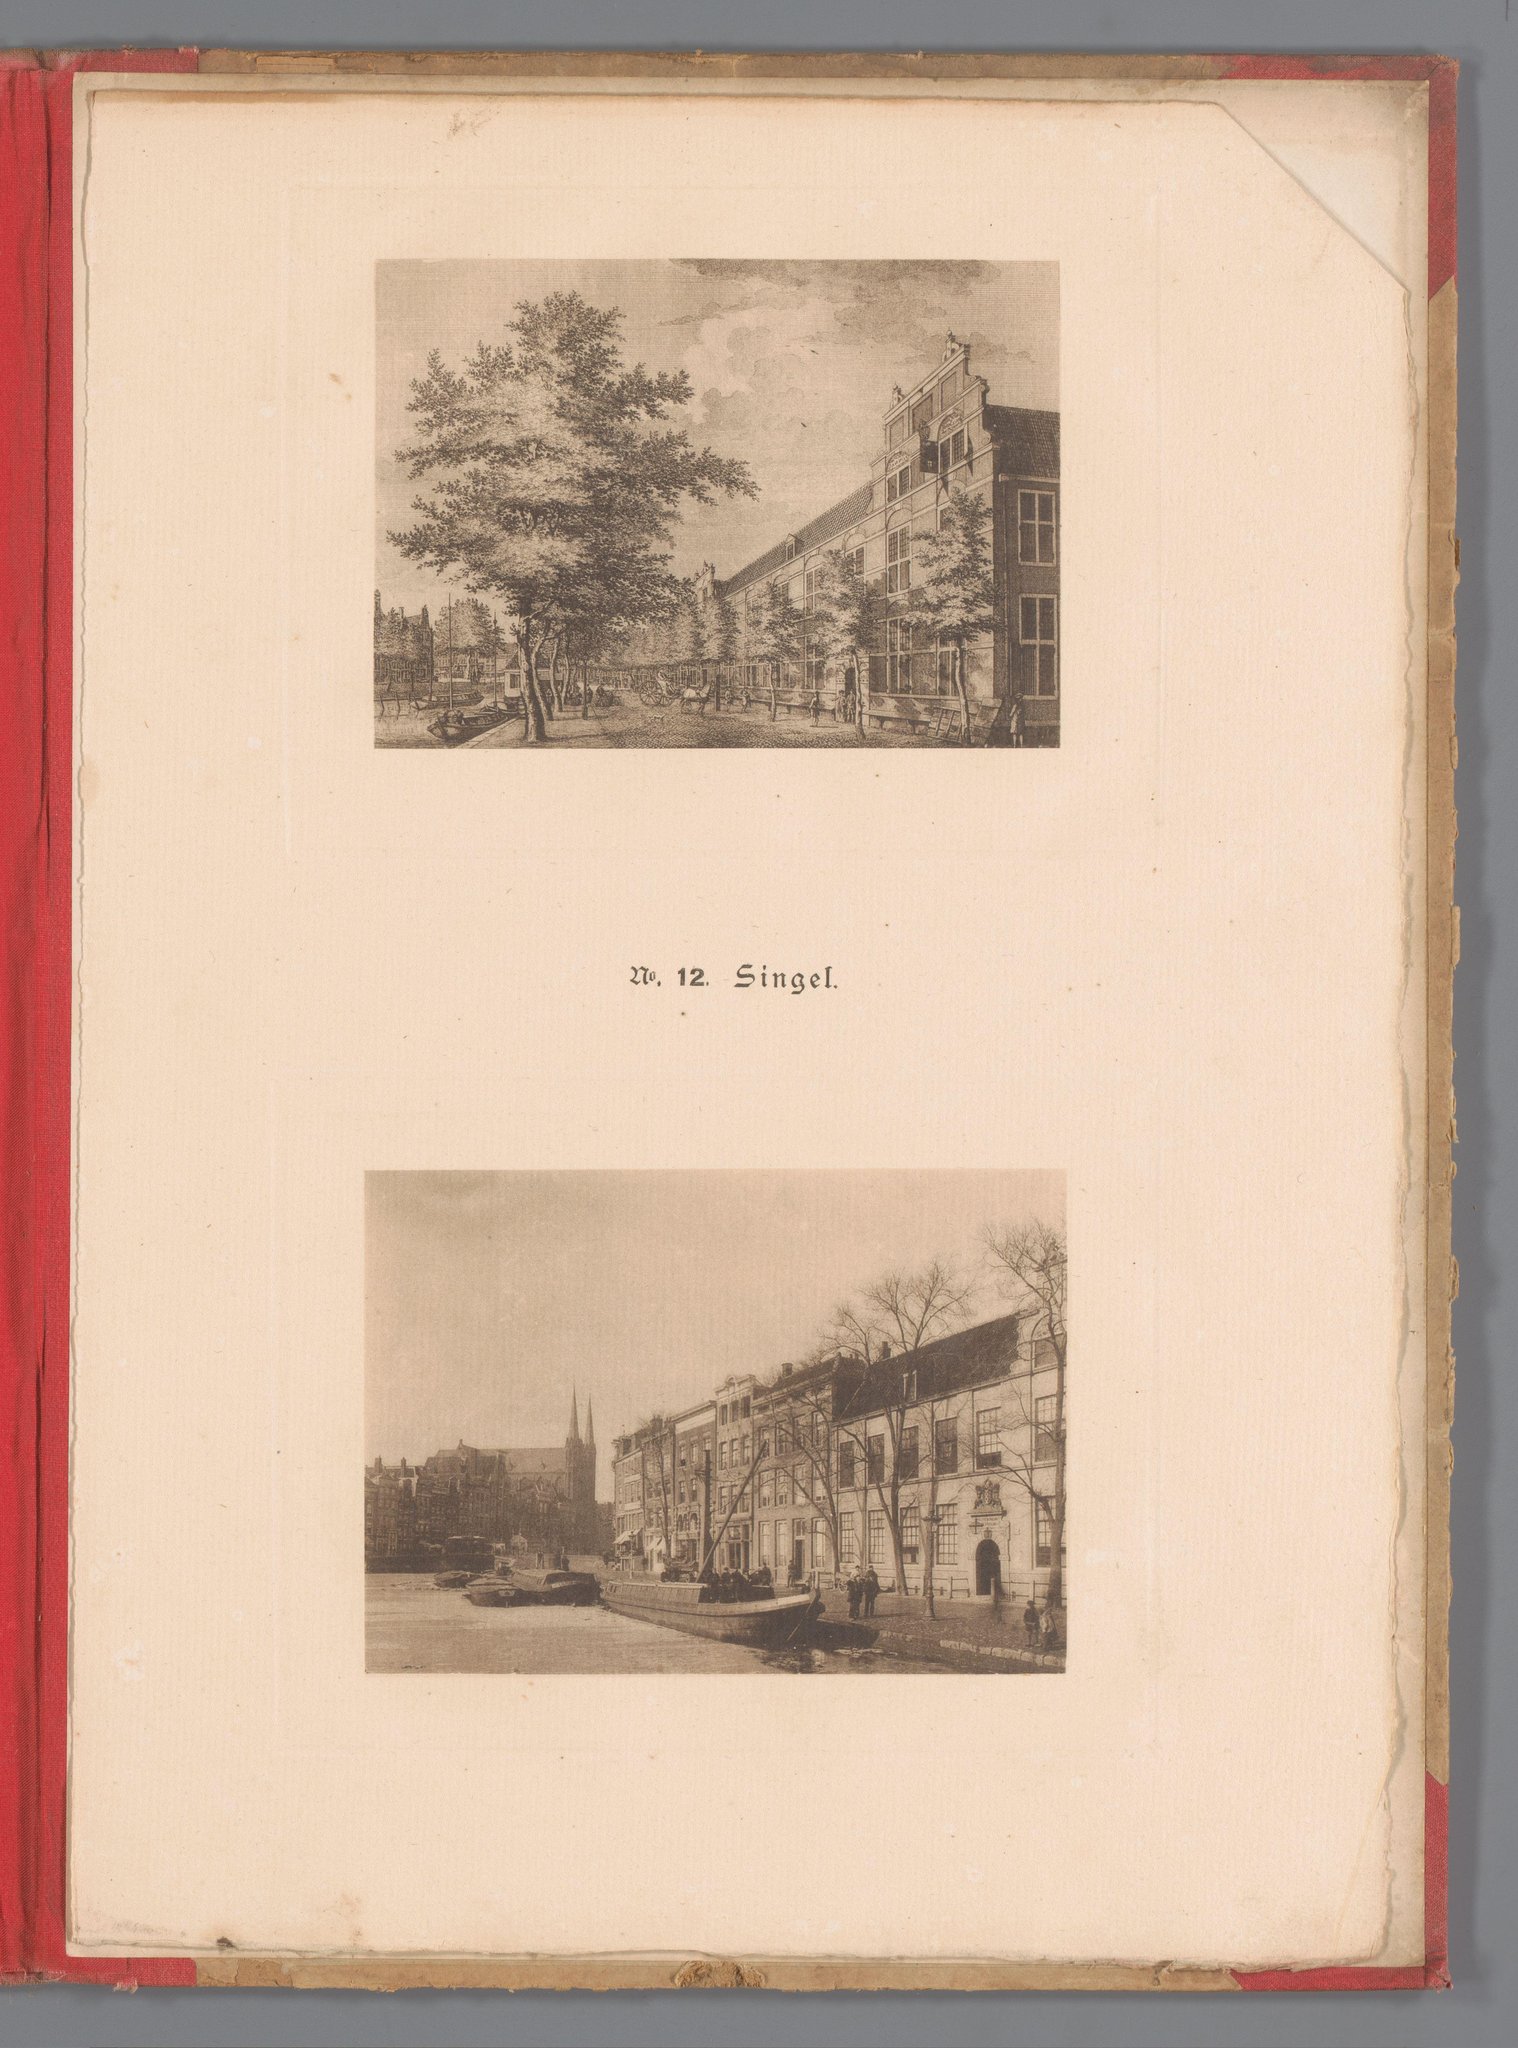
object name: photomechanical print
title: Twee gezichten op de Singel te Amsterdam, waarvan één reproductie van een prent door Hermanus Petrus Schouten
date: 1890-1900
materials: paper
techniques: photograph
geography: amsterdam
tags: secondary education (+ building ~ education, tuition), canals, waters (in city) (+ city(-scape) with figures, staffage), street (+ city(-scape) with figures, staffage)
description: Deze prenten maken deel uit van een album.